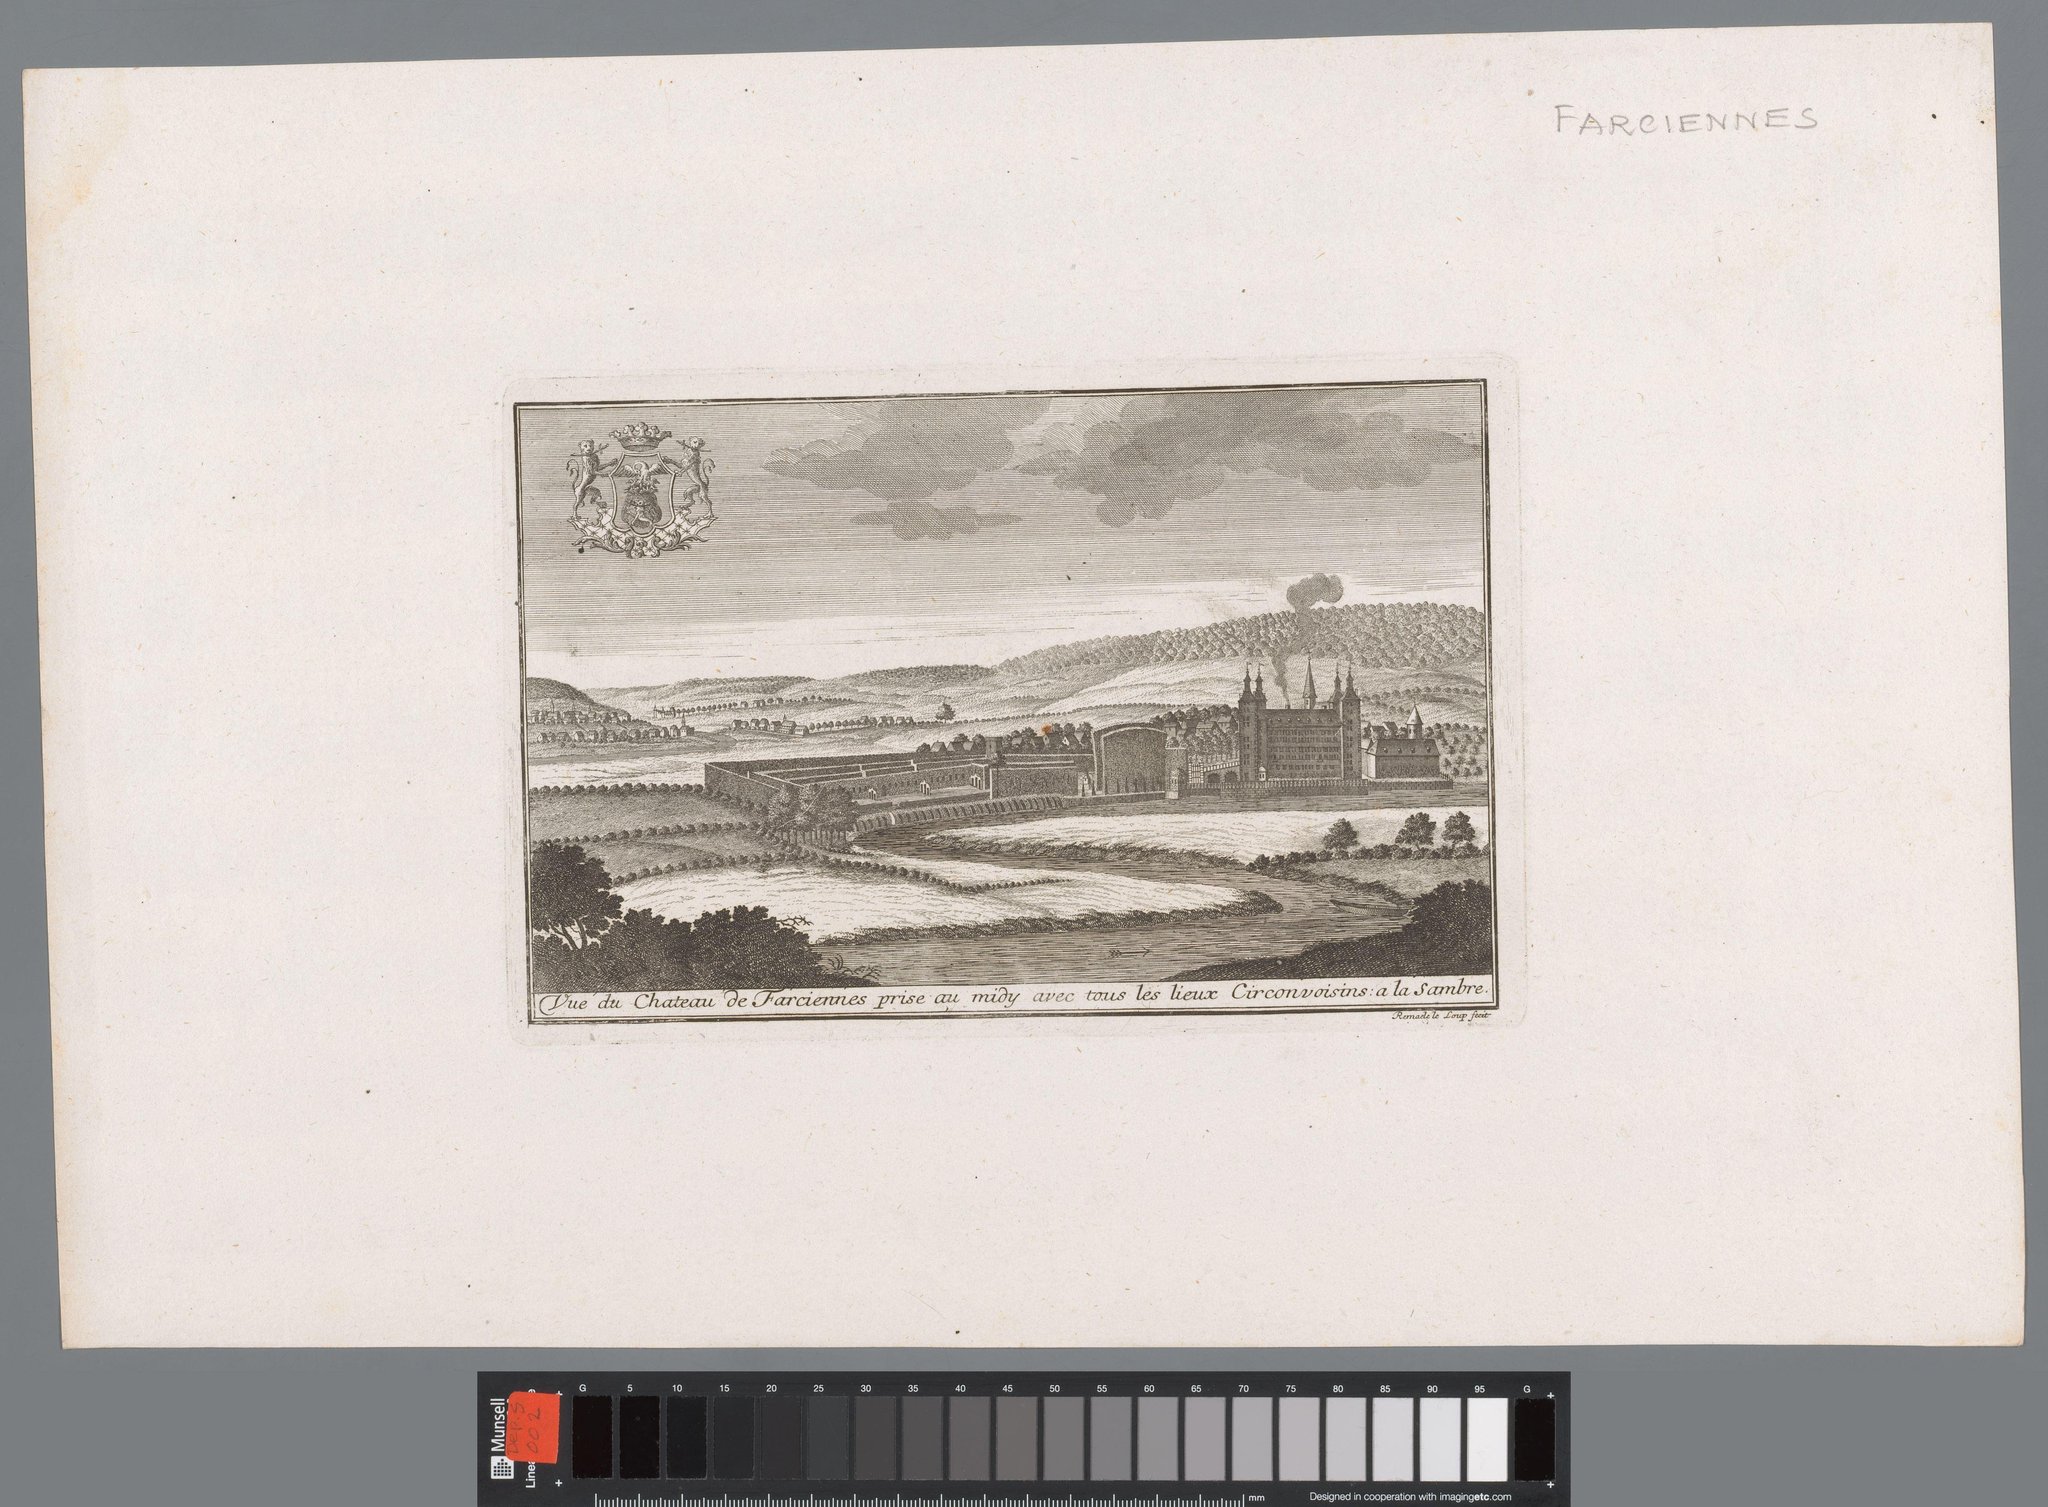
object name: print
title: Vue du Chateau de Farciennes prise au midy avec tous les lieux circonvoisins: a la Sambre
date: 1738-1744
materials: paper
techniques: engraving, etching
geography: liège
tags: castle, landscape with tower or castle, henegouwen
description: Prent uit: Johanne de Saumery, Alexandre de et al. Les délices du païs de Liège, ou description géographique, topographique et chorographique des monumes sacrés et profanes (...). 5 dln. Luik: Everard Kints, 1738-1744, dl. 2, p. 327.